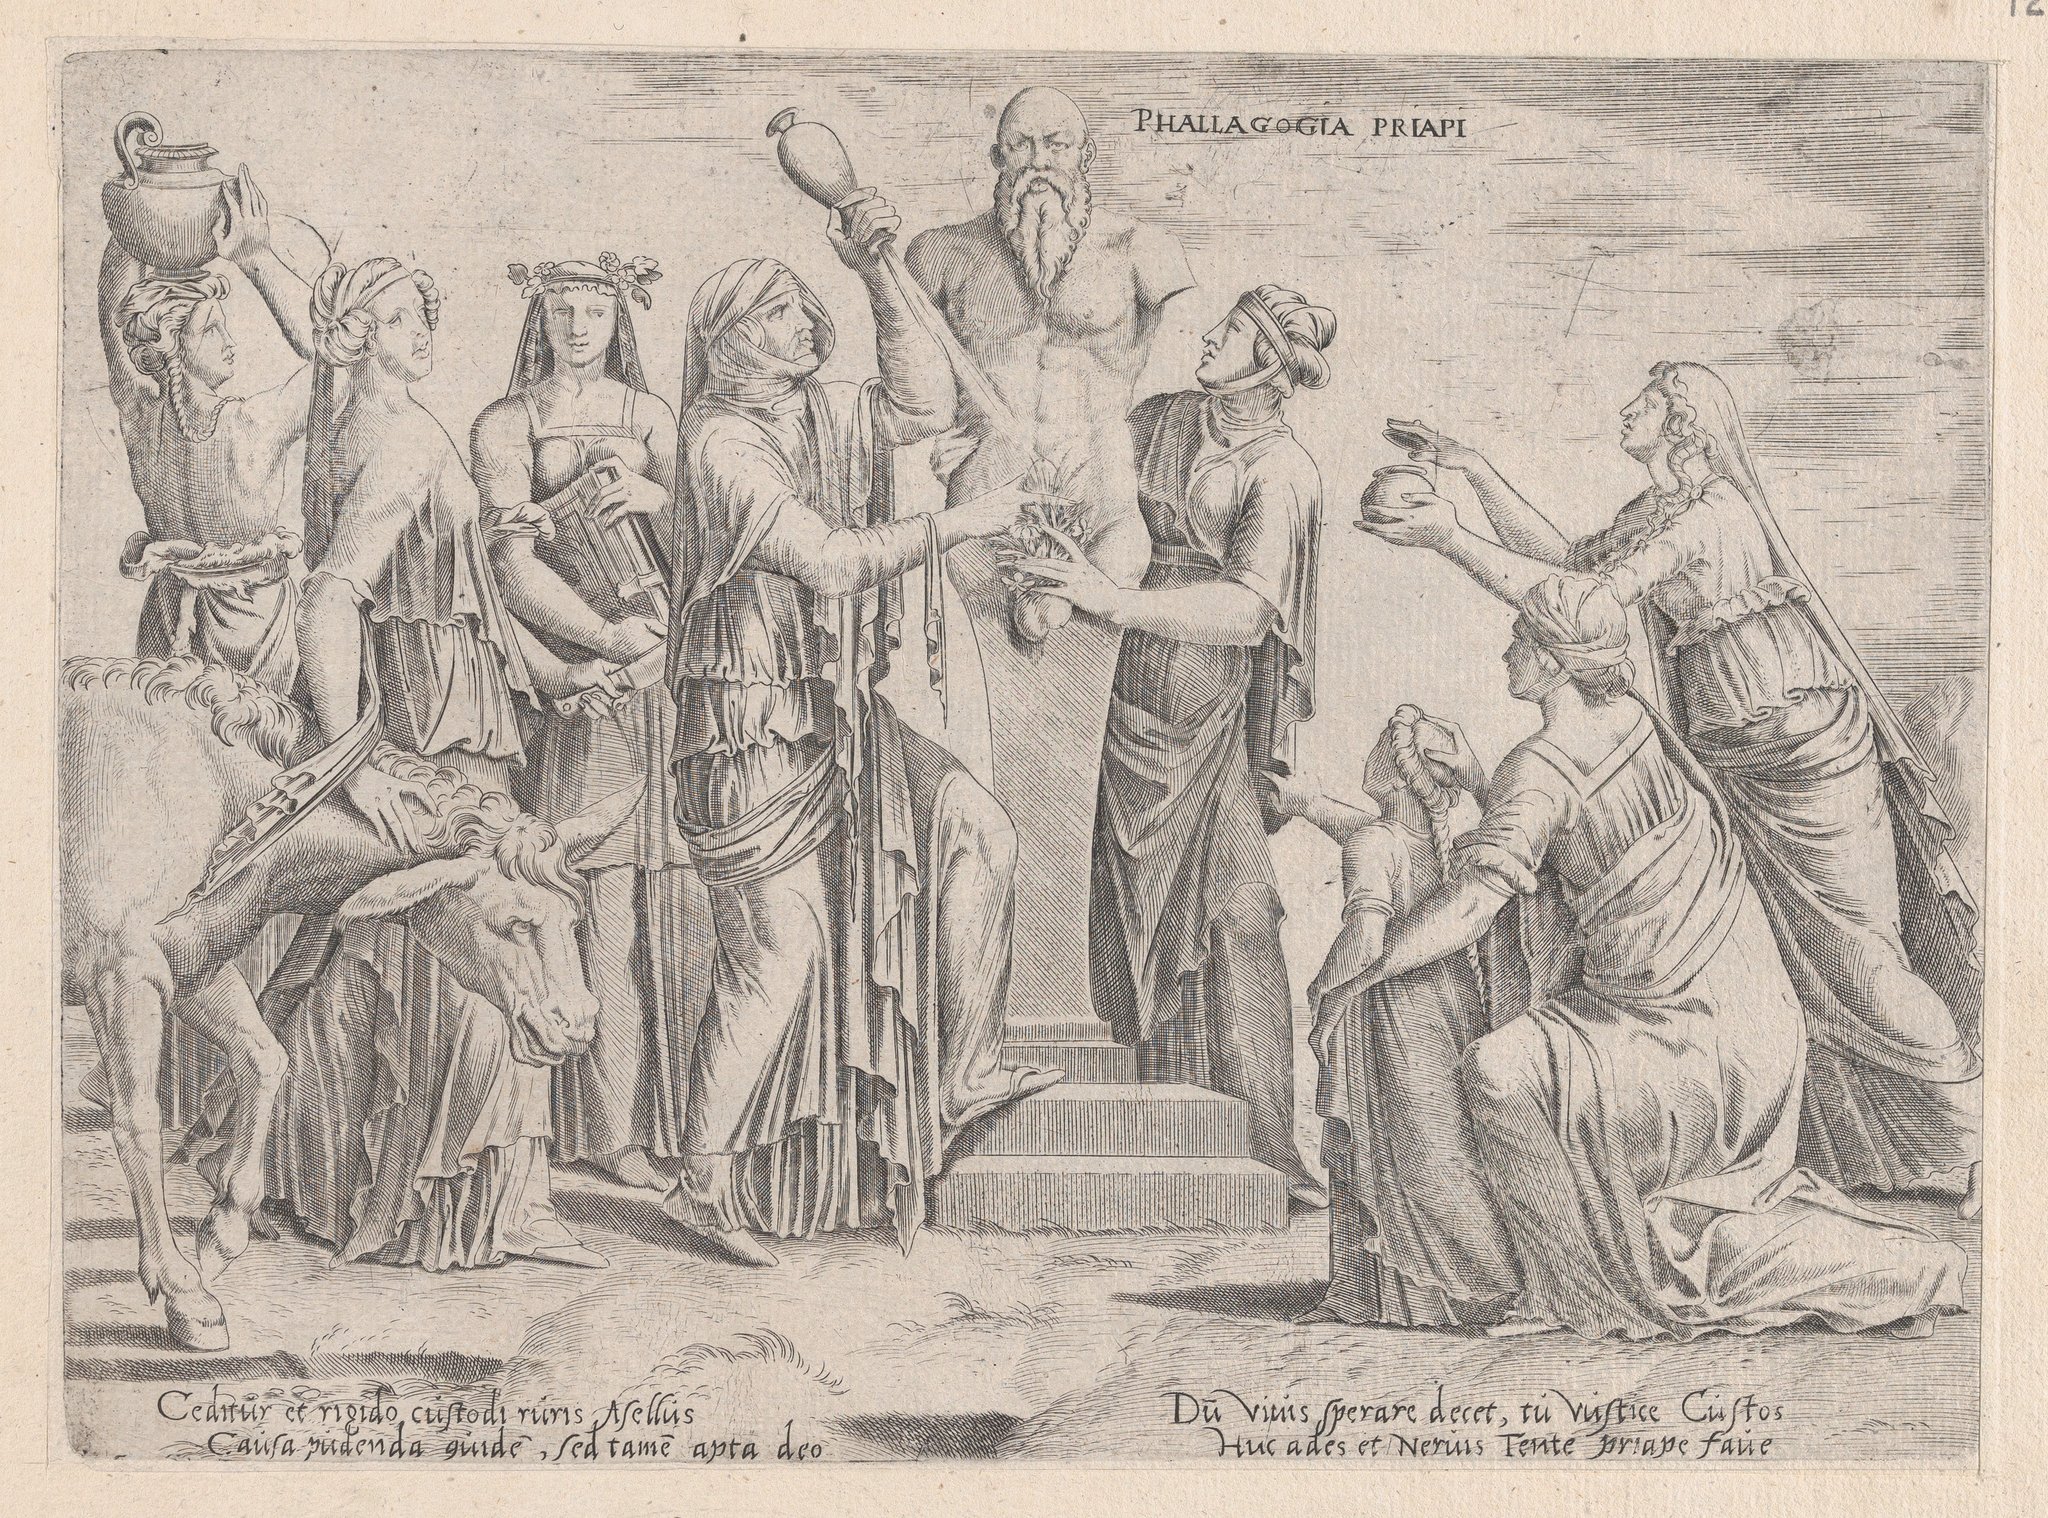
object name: print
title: Eight Women Sacrificing to Priapus, from "Speculum Romanae Magnificentiae"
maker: cornelis bos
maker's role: artist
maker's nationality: netherlandish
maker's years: 1510-1556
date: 1501-1600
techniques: engraving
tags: animals,women